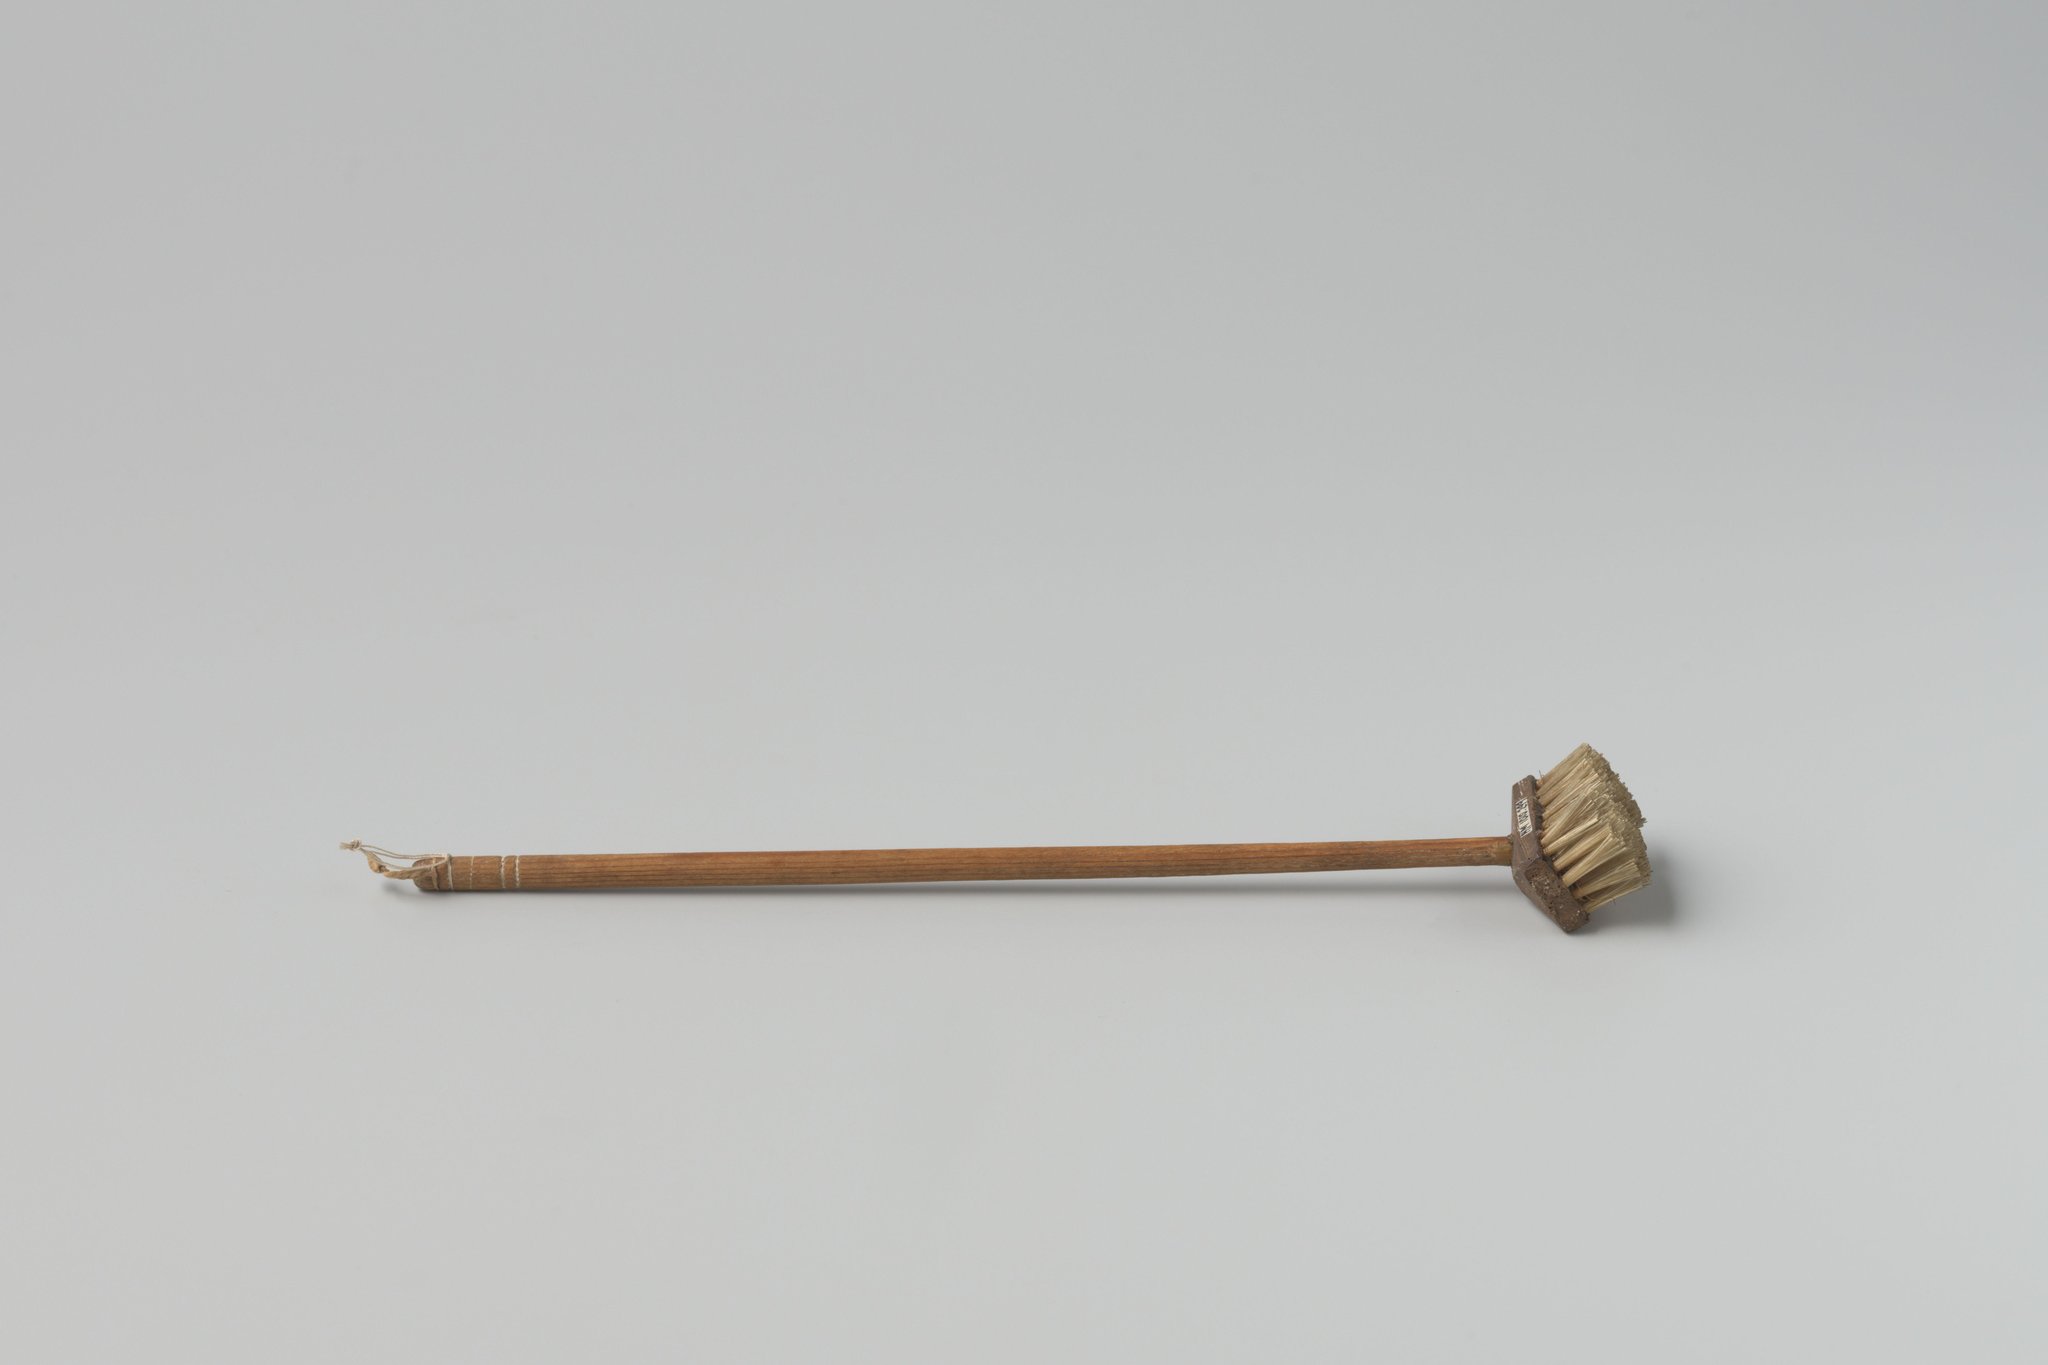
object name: broom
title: Luiwagen, kop van eikenhout ingezet met varkenshaar, gladde steel van grenenhout met bovenaan vijf profielringen (voor touwtje)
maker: Anonymous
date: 1690-1710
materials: wood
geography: amsterdam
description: Luiwagen, kop van eikenhout ingezet met varkenshaar, gladde steel van grenenhout met bovenaan vijf profiel ringen (voor touwtje).